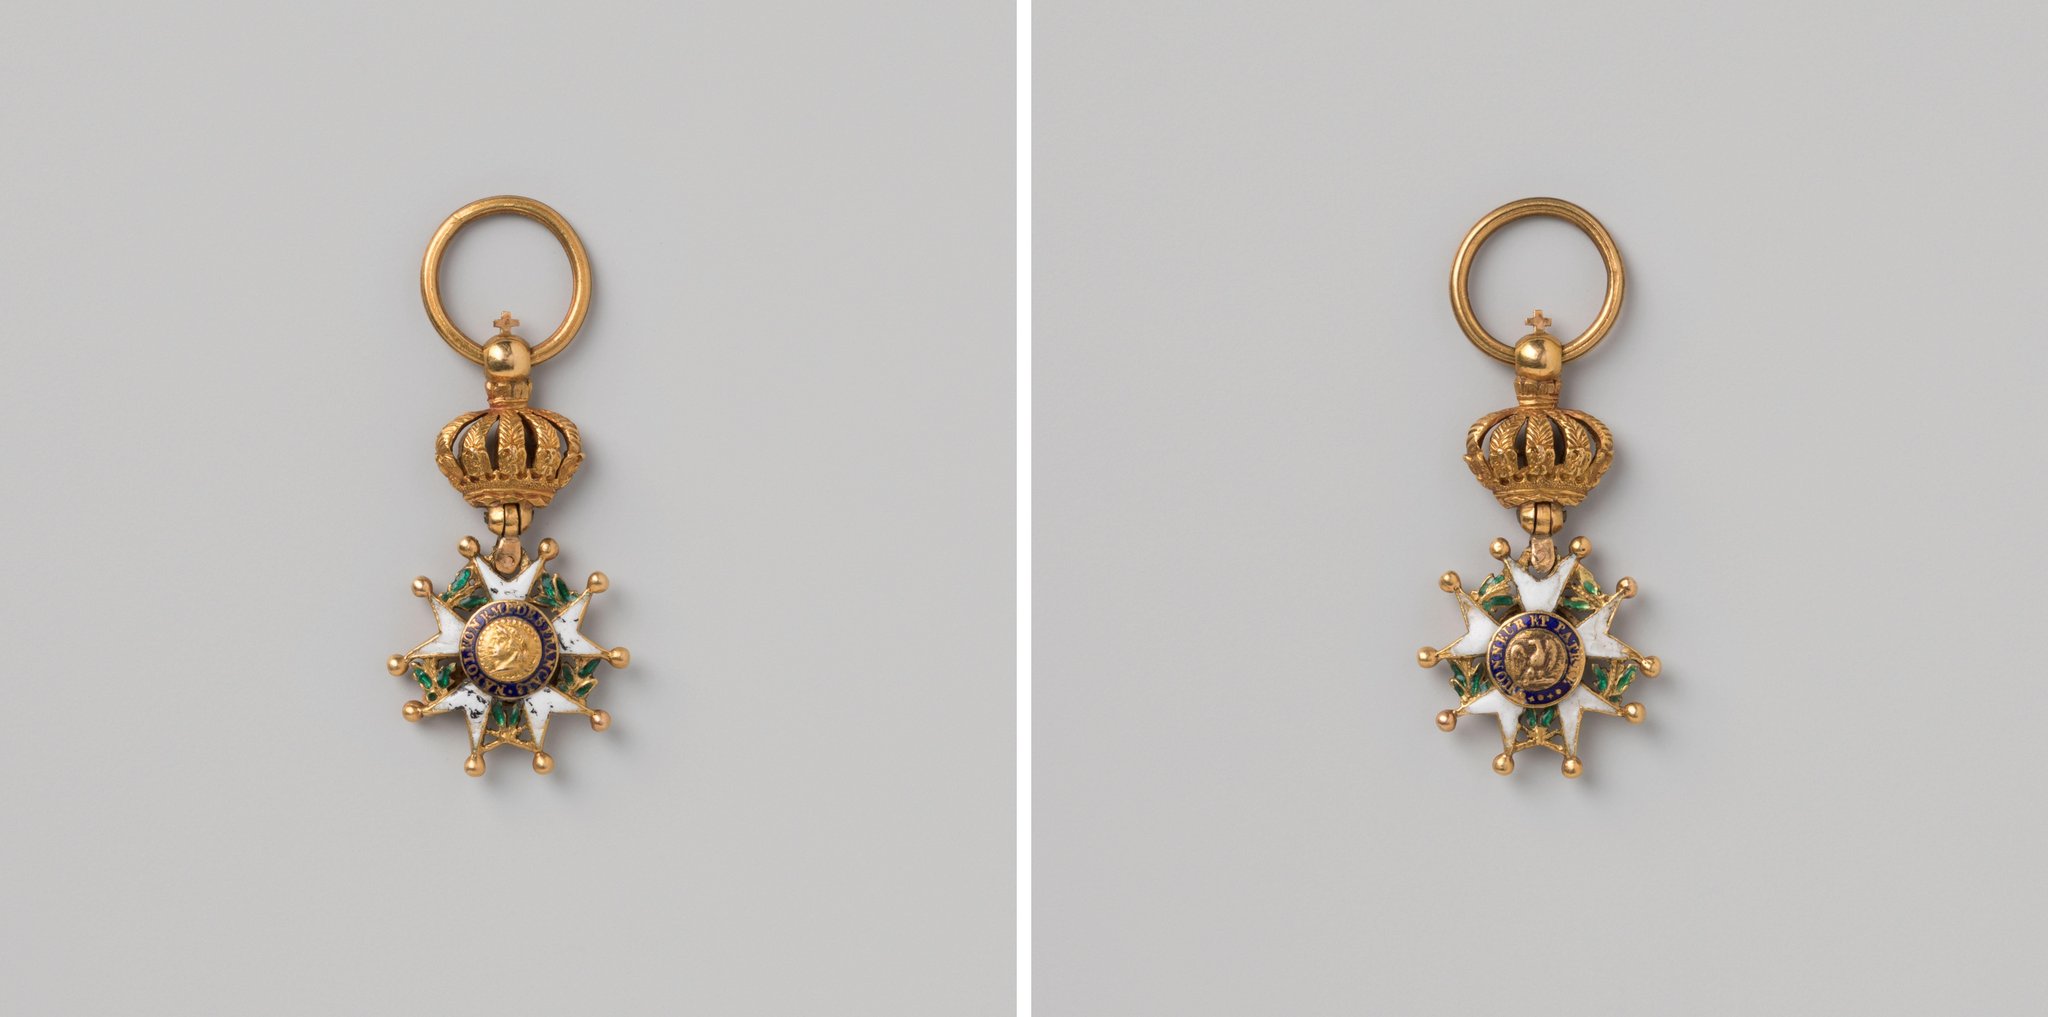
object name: ordeteken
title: Ordeteken van het Legioen van Eer van I. J. A. Gogel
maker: Anonymous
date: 1811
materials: gold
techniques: casting, forging, striking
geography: france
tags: napoleon i (emperor of the french)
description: Decorations and medals, 1806-1813. King Louis Napoleon instituted two national orders: the Order of Merit, with the motto 'do well and do not look back', and the Order of the Union, with the motto 'luctor et emergo'. A year later the two orders were merged to form the Royal Order of Holland, renamed the Royal Order of the Union after 1808. Instead of the king's head, the medal showed a bundle of arrows. When the Netherlands was annexed by France in 1810, Emperor Napoleon introduced the Order of Reunion to replace the Order of the Union. These decorations were originally awarded to I.J.A. Gogel, who served for many years as minister of finance.